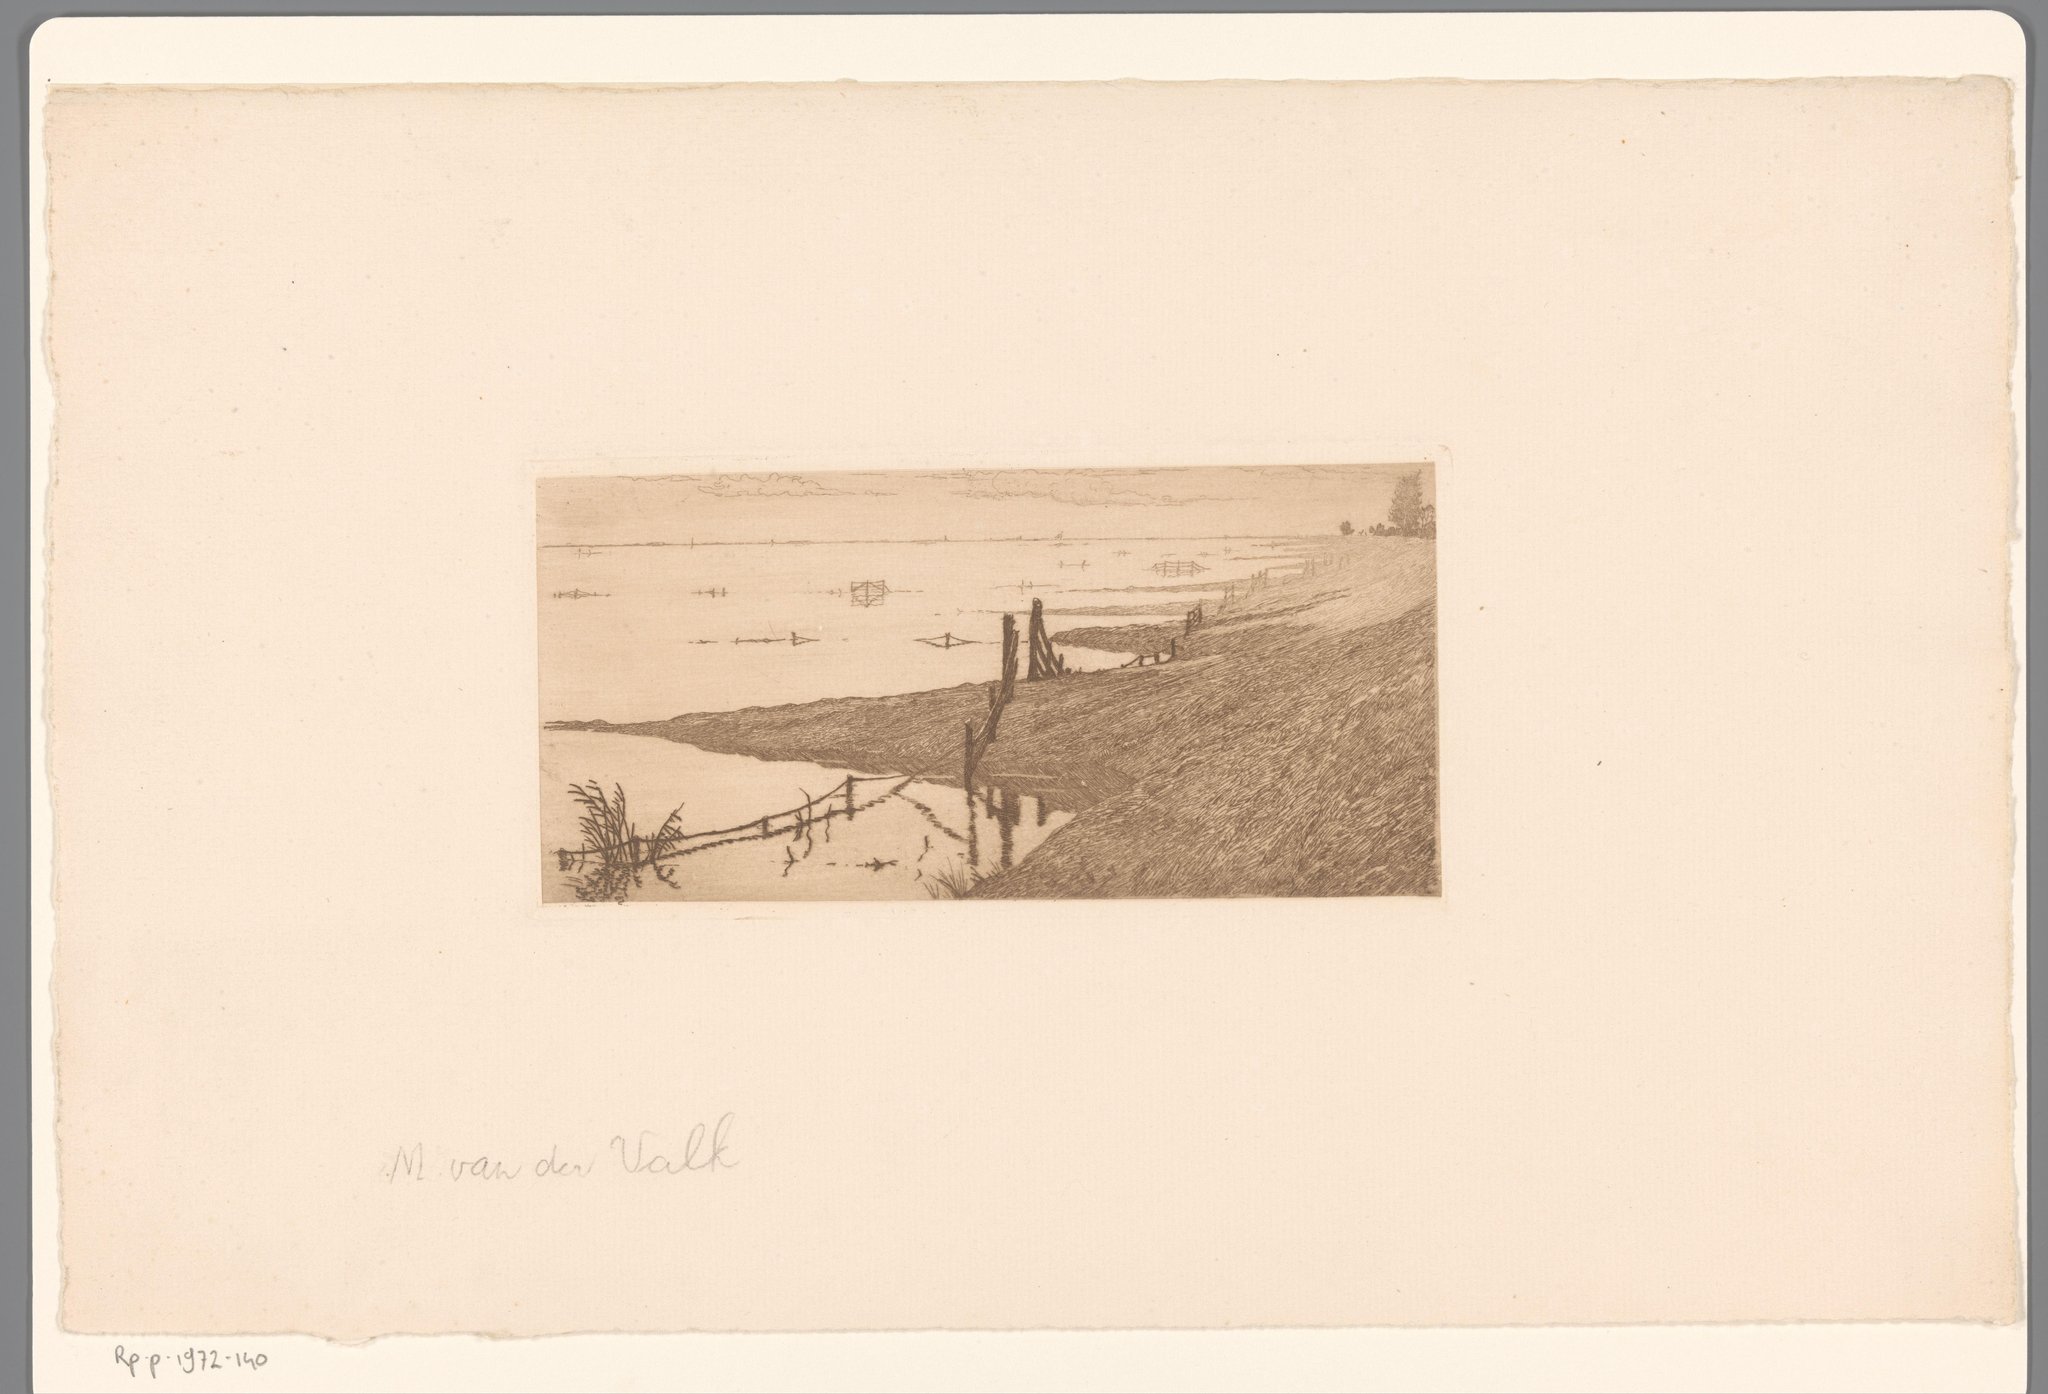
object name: print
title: Ondergelopen weilanden bij een dijk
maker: maurits van der valk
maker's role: draughtsman, print maker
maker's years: 1857-1935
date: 1867-1935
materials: paper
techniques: etching, intaglio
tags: water meadows under water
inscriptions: collector's mark: Lugt 2228, collector's mark: Lugt 2760